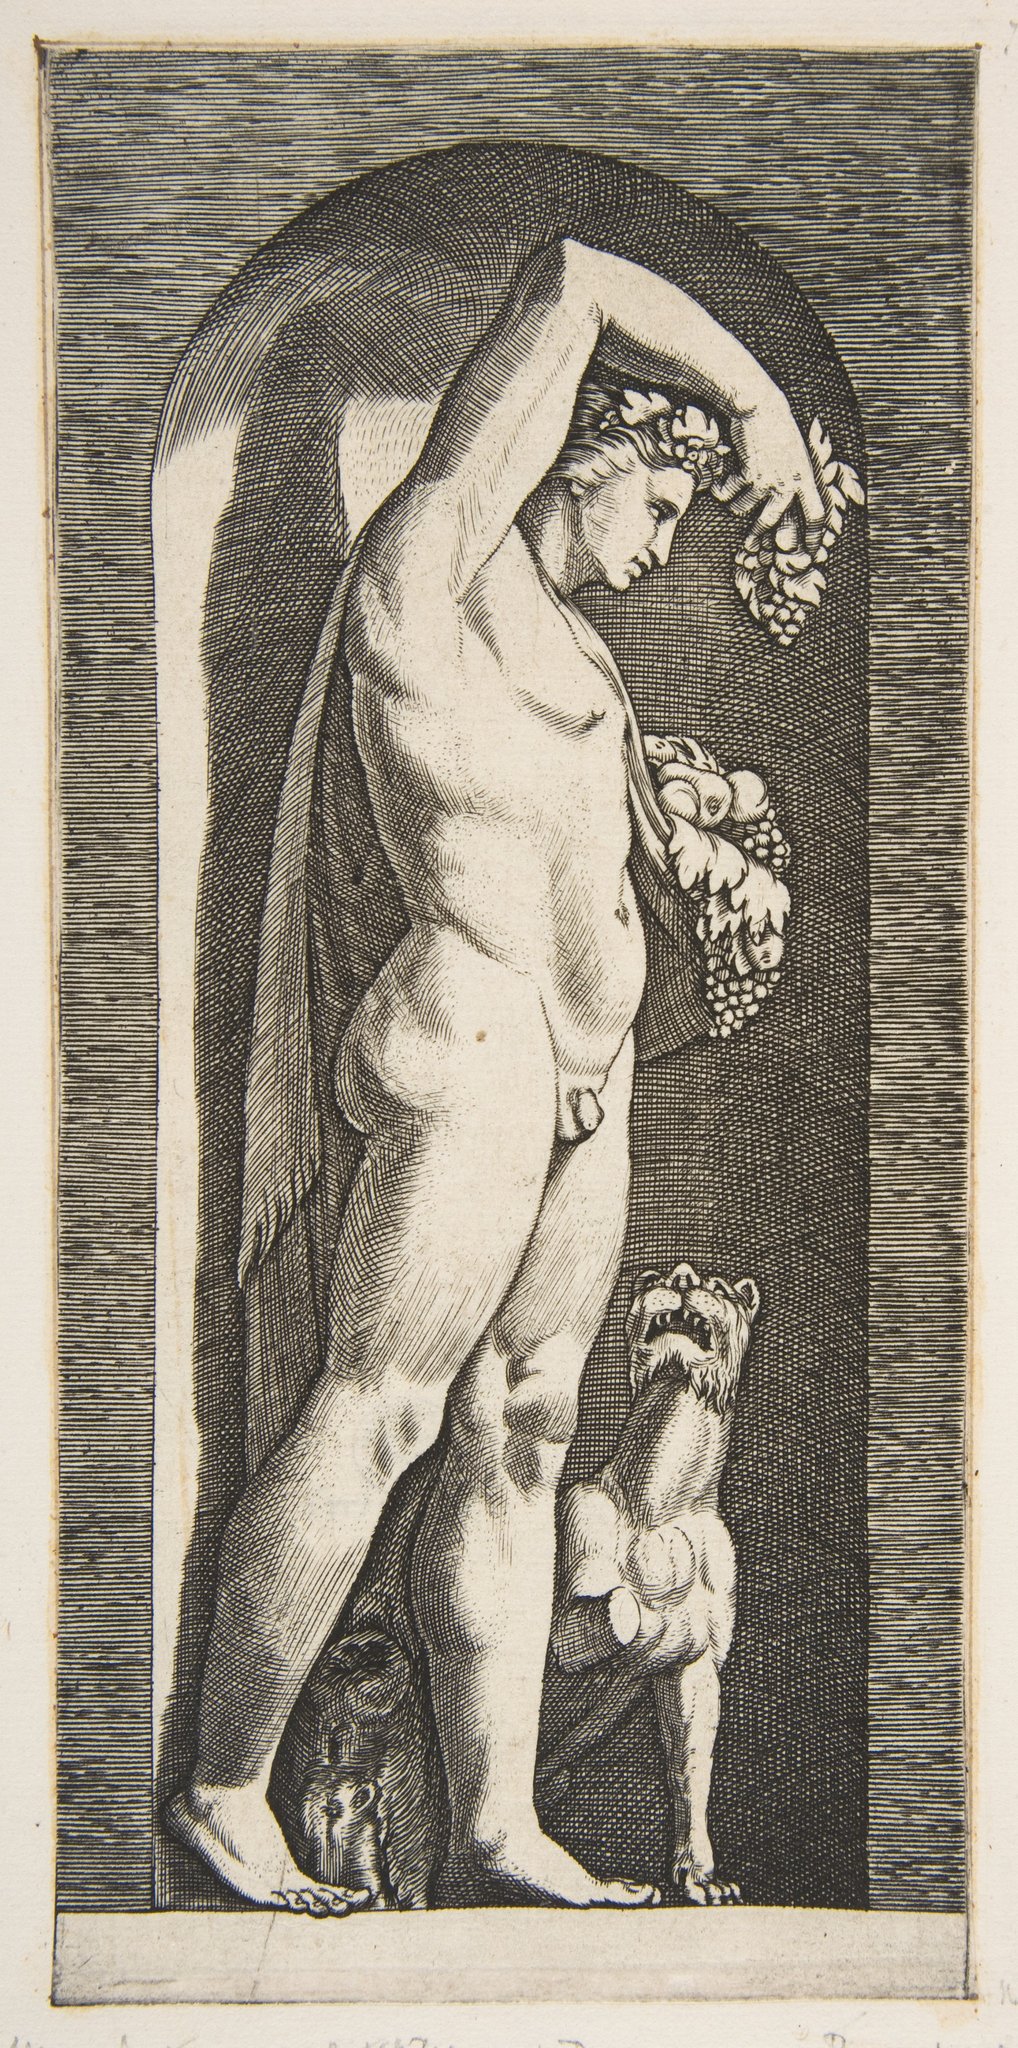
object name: print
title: Bacchus standing in a niche holding grapes in his raised right hand, fruit in his left hand, a dog lower right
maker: marco dente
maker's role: artist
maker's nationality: italian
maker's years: 1515-1527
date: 1515-1527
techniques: engraving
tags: grapes,bacchus,dogs